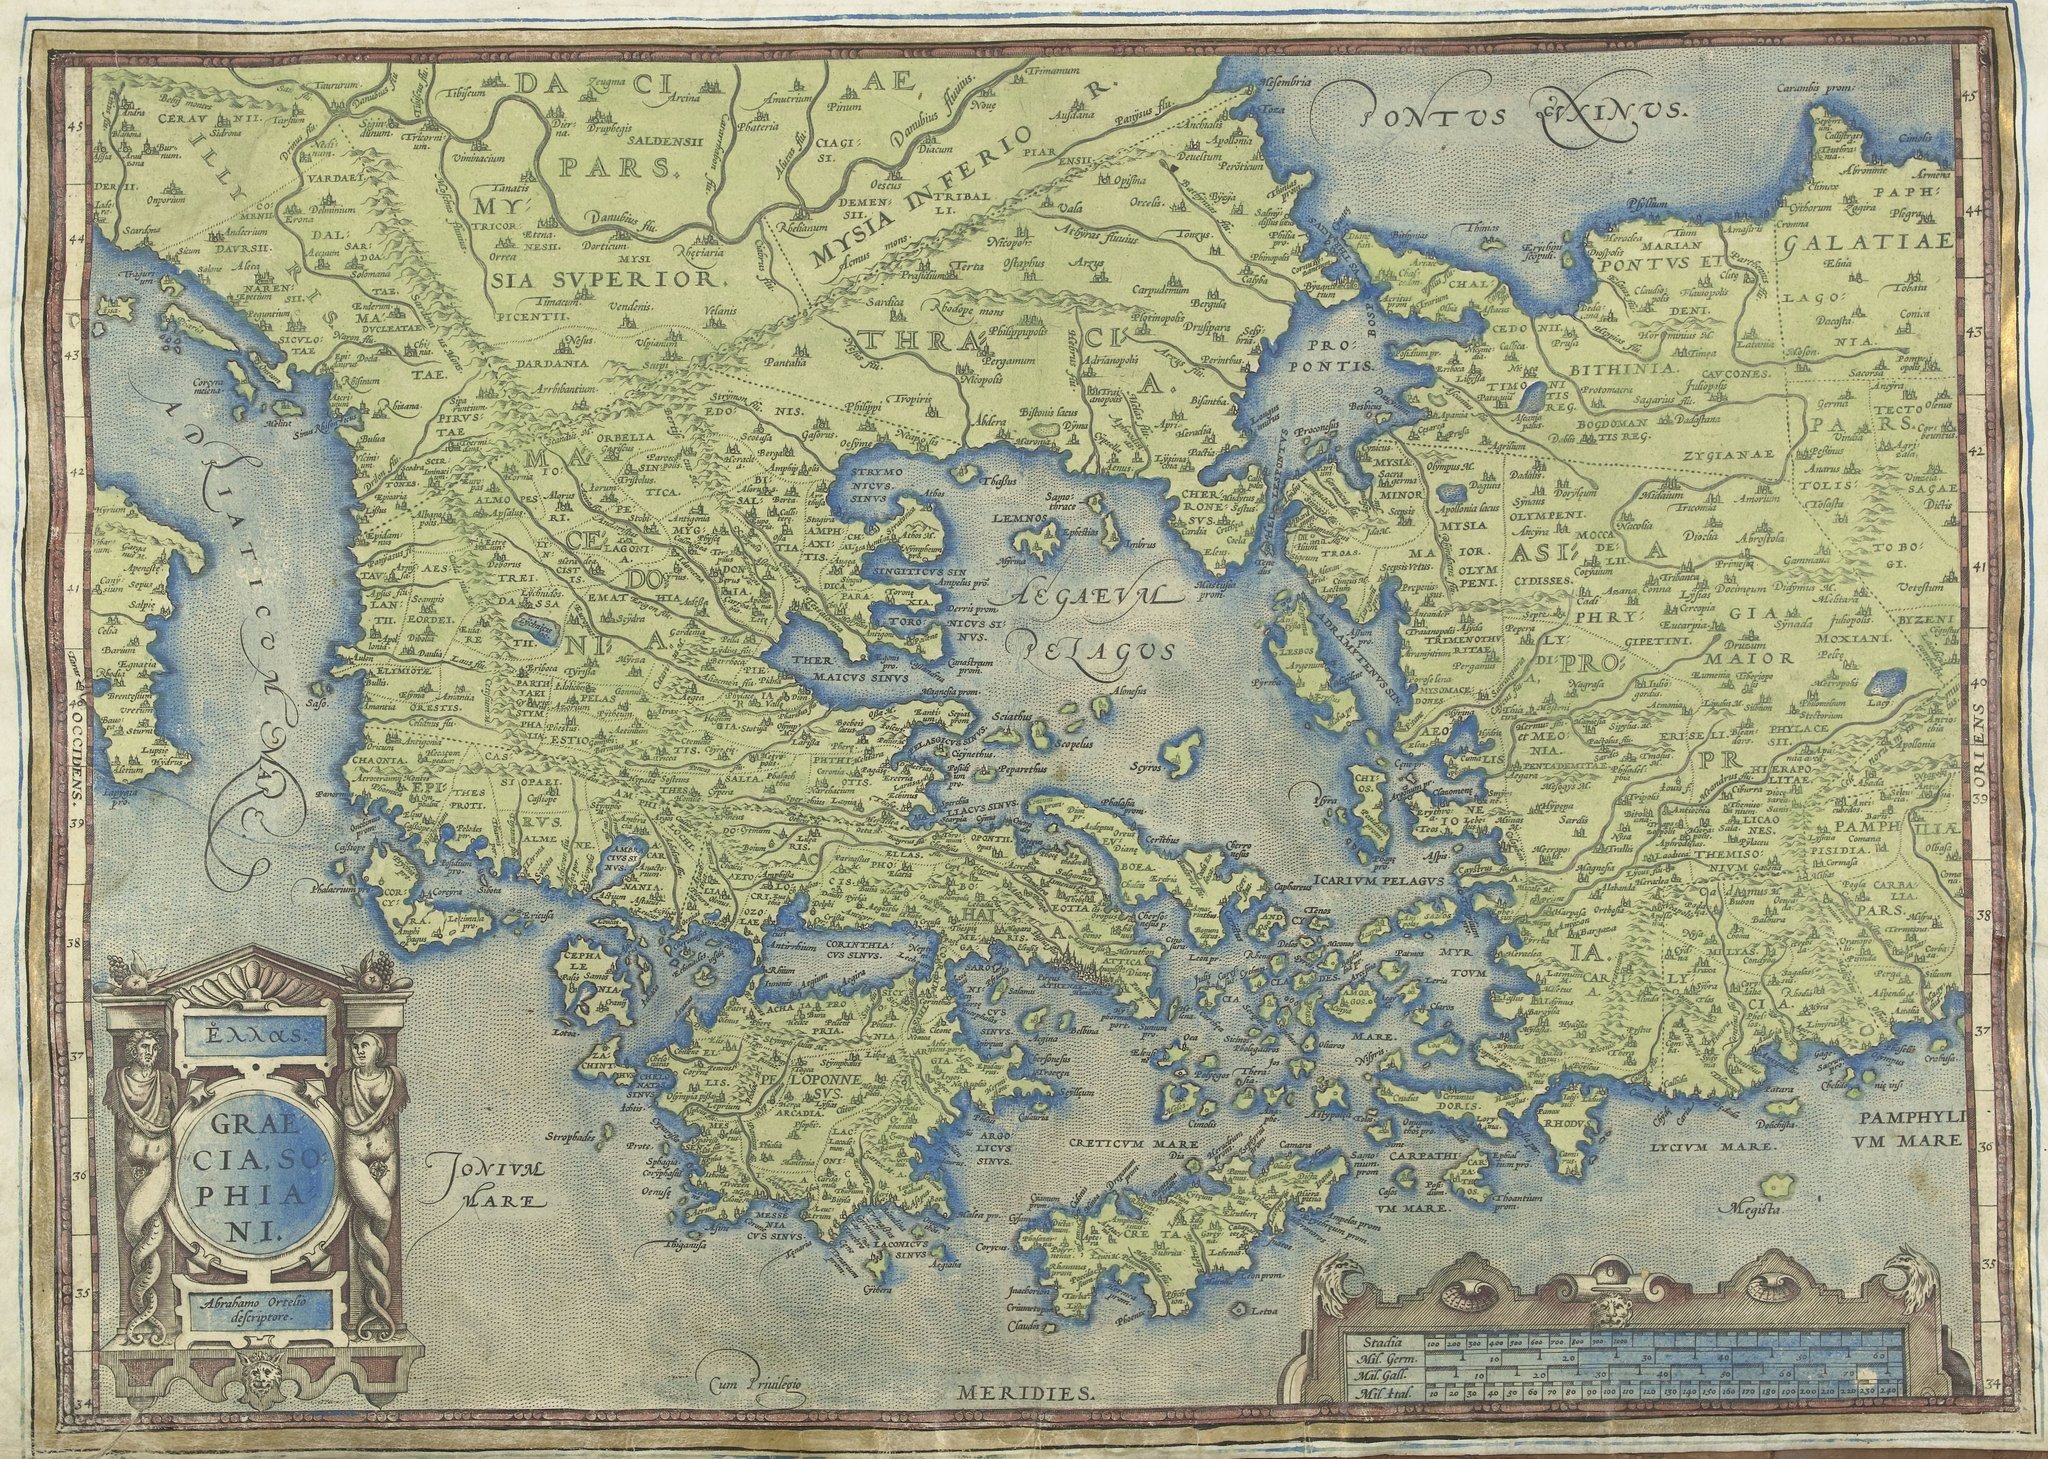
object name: album leaf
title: Graecia, Sophiani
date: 1542-1598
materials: paper, parchment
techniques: engraving, hand coloring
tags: maps of separate countries or regions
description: Kaart van Griekenland. Linksonder de titel in een ornamentele architecturale omlijsting. Rechtsonder een schaalverdeling. Deze prent maakt deel uit van een album.